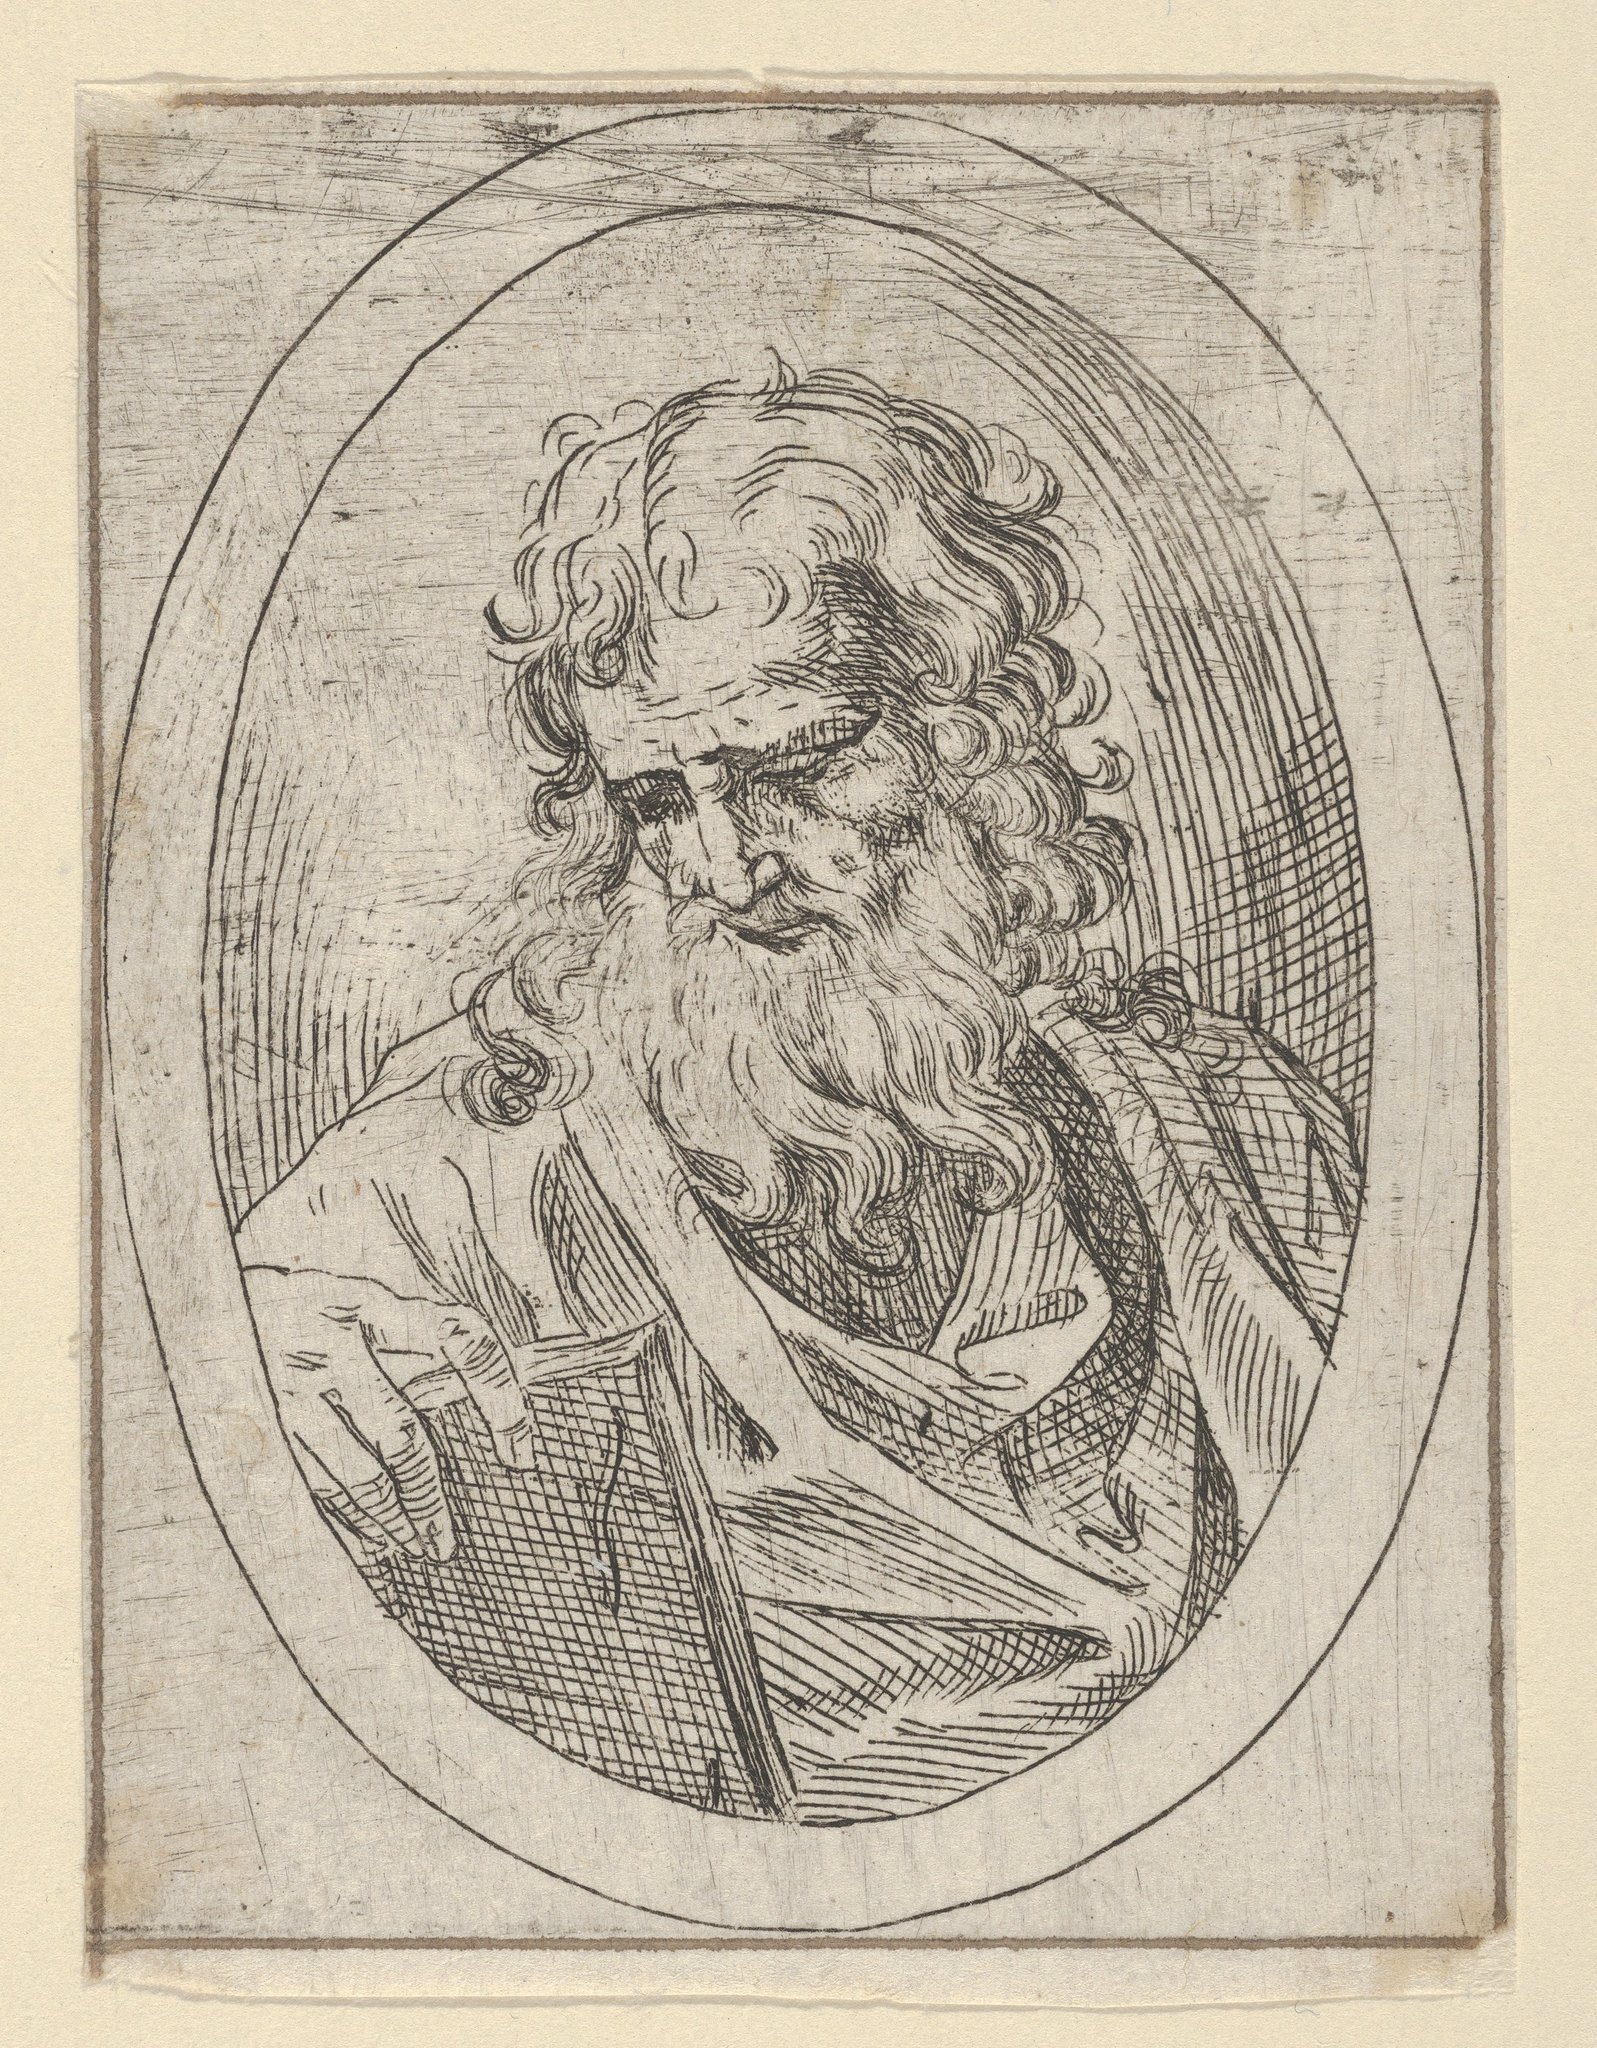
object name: print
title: An apostle with a long beard looking down at an open book, in an oval frame, from "Christ, the Virgin, and Thirteen Apostles"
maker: anonymous, 17th century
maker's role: artist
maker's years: 1600-1700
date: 1600-1640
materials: ink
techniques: etching, pen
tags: reading,apostles